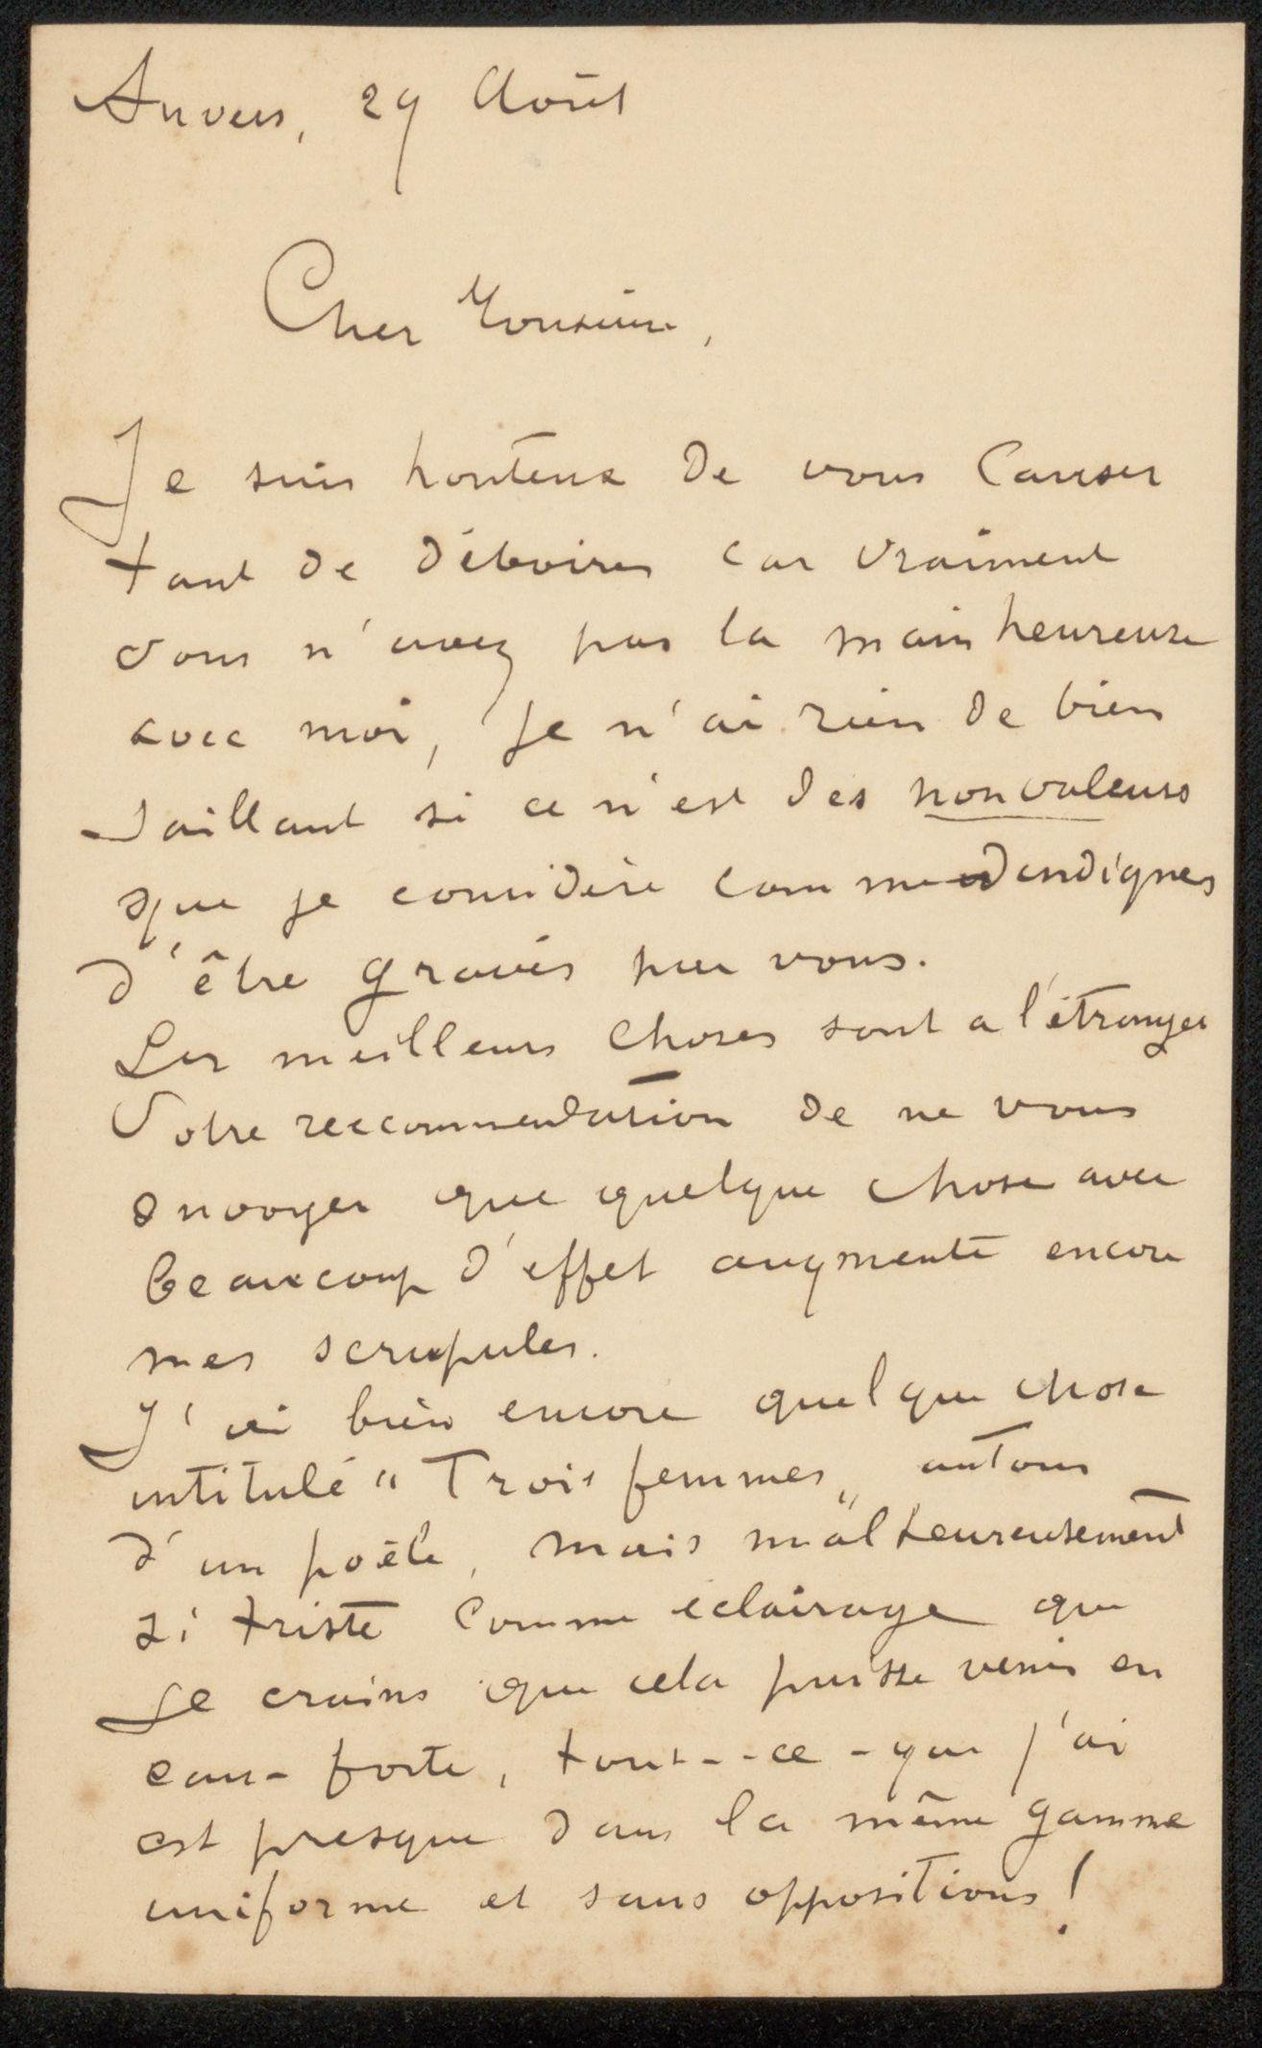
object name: letter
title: Brief aan Philip Zilcken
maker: charles mertens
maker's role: print maker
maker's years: 1865-1919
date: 1901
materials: ink, paper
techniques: pen, writing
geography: antwerp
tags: the hague, painter, philip zilcken, the graphic arts, exhibition ~ art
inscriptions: watermark, collector's mark: ‘RPK’